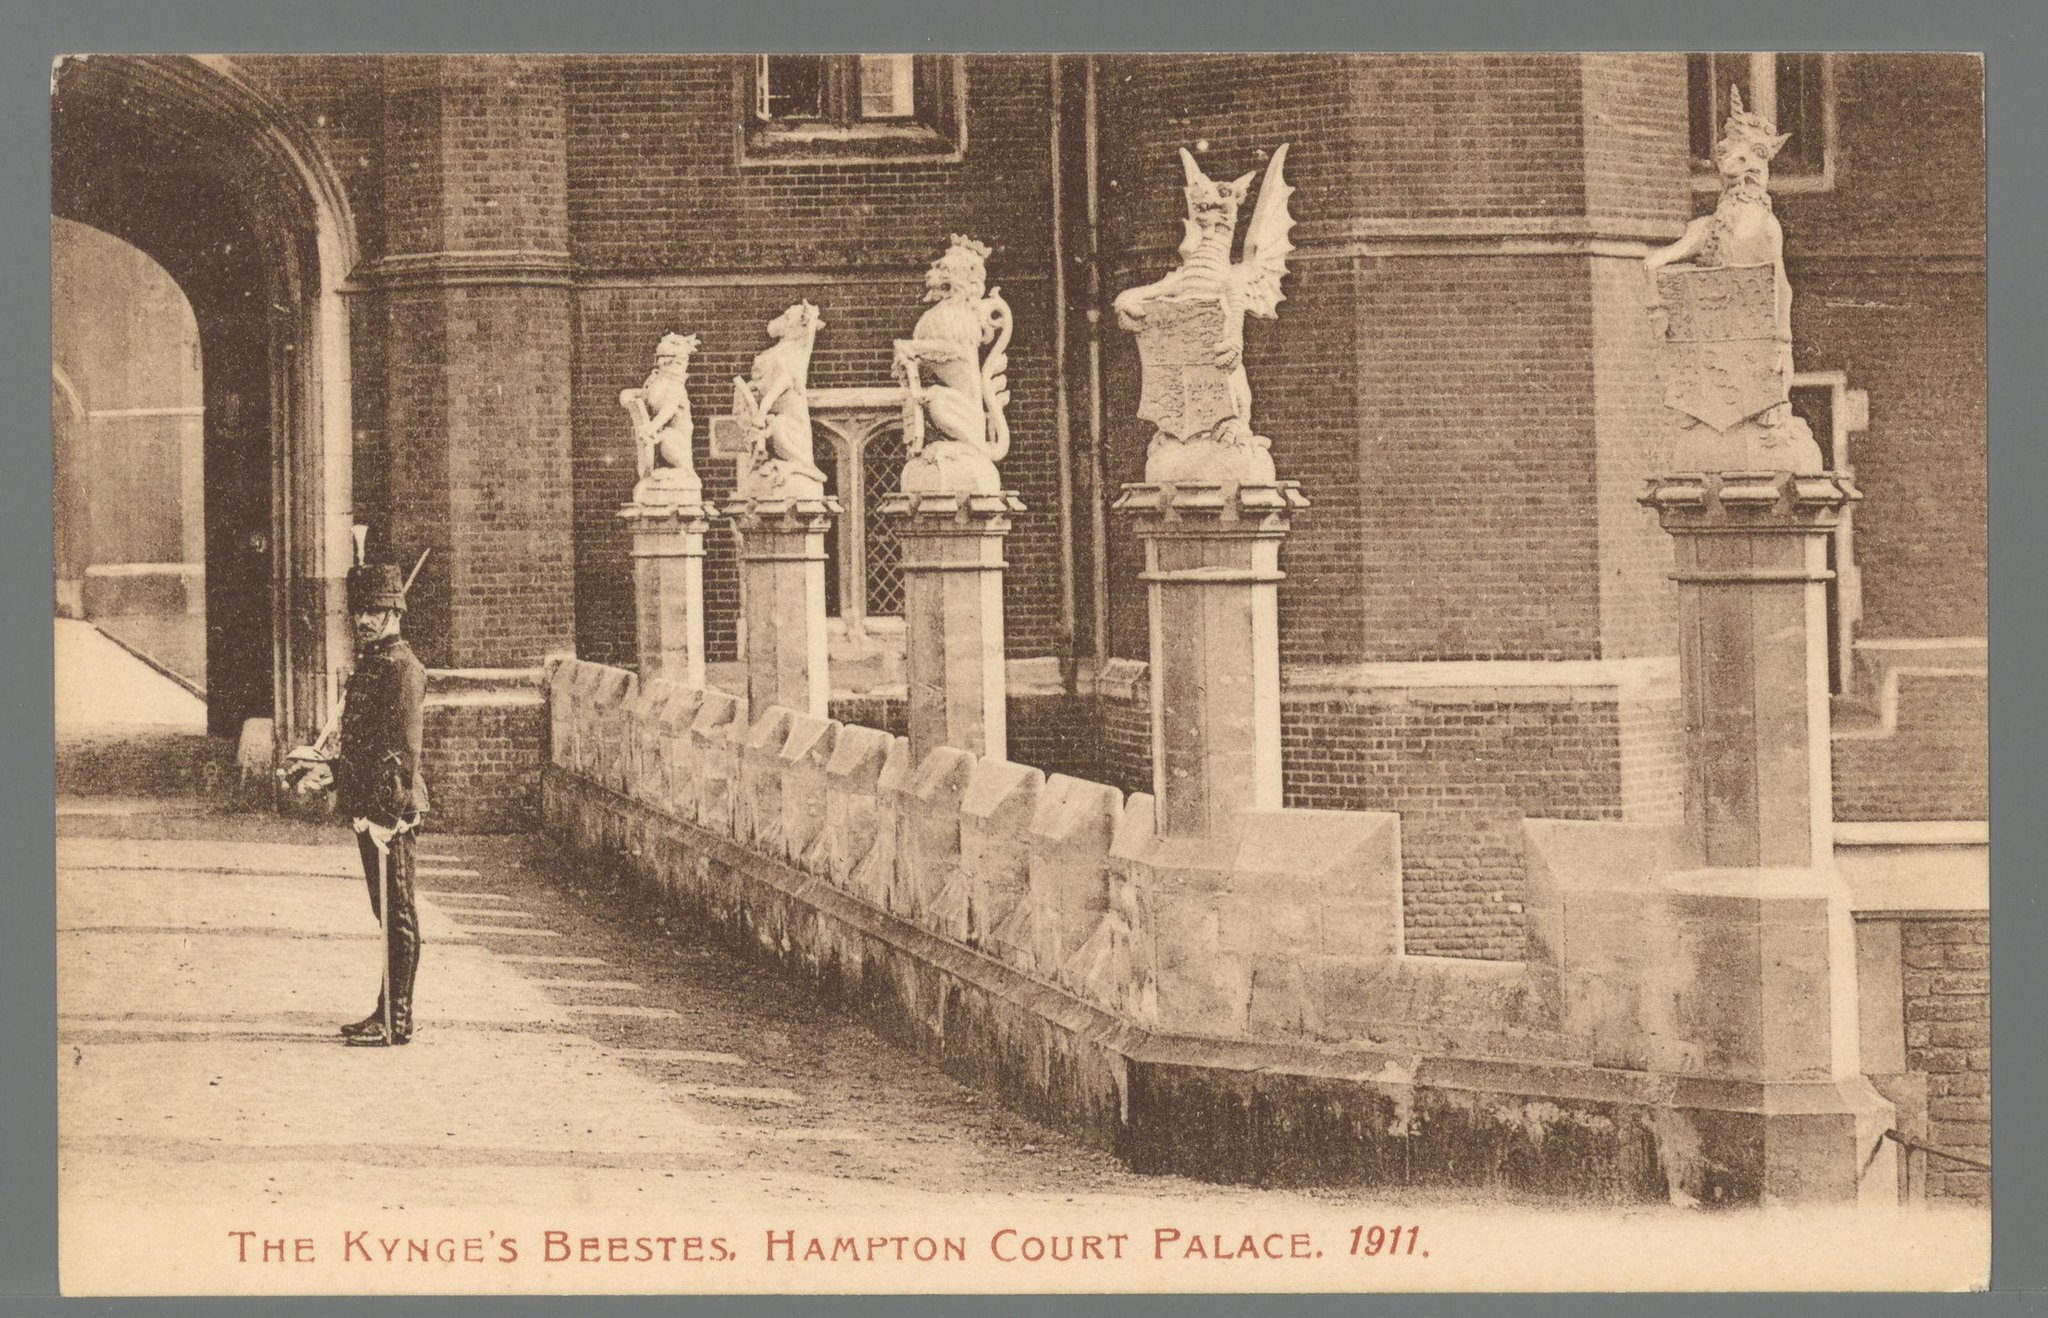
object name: photomechanical print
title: The Kynge's Beestes. Hampton Court Palace. 1911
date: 1911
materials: cardboard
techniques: photograph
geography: england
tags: palace, gate, entrance, monument, statue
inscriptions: date